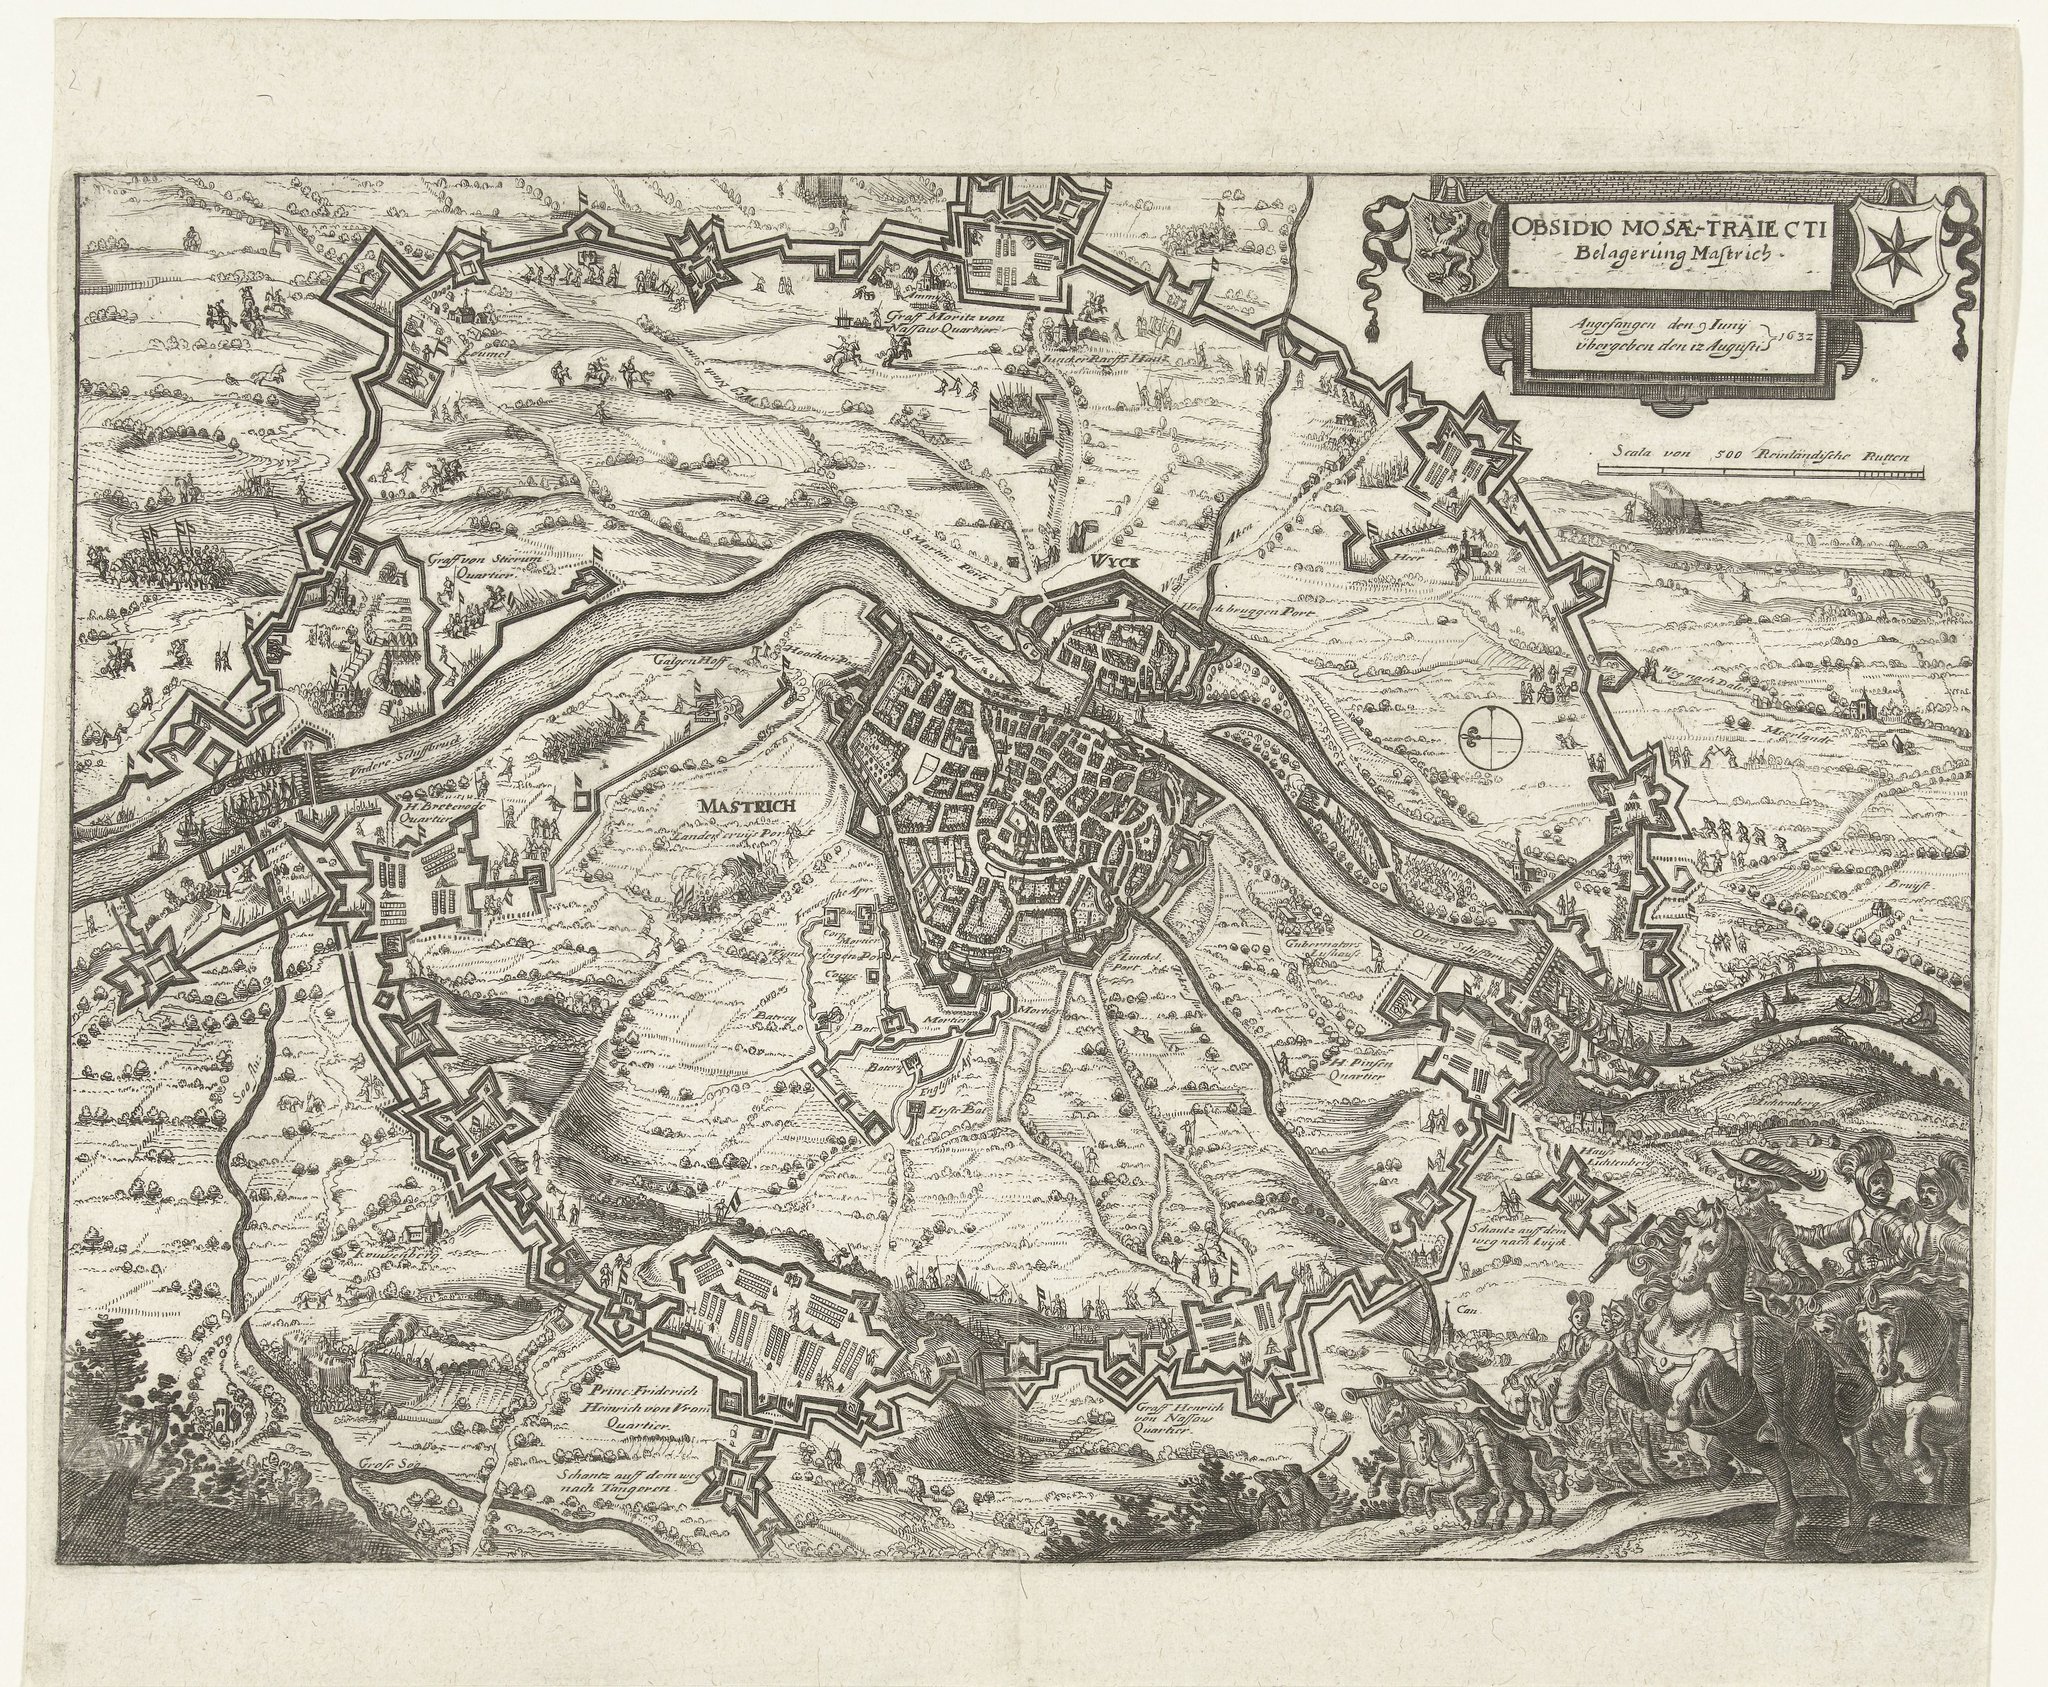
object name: print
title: Obsidio Mosae-Trajecti Belagerung Mastrich / Angefangen den 9. Junij übergeben den 12. Augusti 1632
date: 1632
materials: paper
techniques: engraving, etching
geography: germany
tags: delft, frederick henry (prince of orange), maps of separate countries or regions, siege, position war, maps of cities, maastricht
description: Kaart van het beleg van Maastricht door het Staatse leger onder stadhouder Frederik Hendrik, 9 juni tot 21 augustus 1632. Omsingeling van de stad met de verschillende legerkampen van de belegeraars. Rechtsonder de stadhouder met officieren te paard.